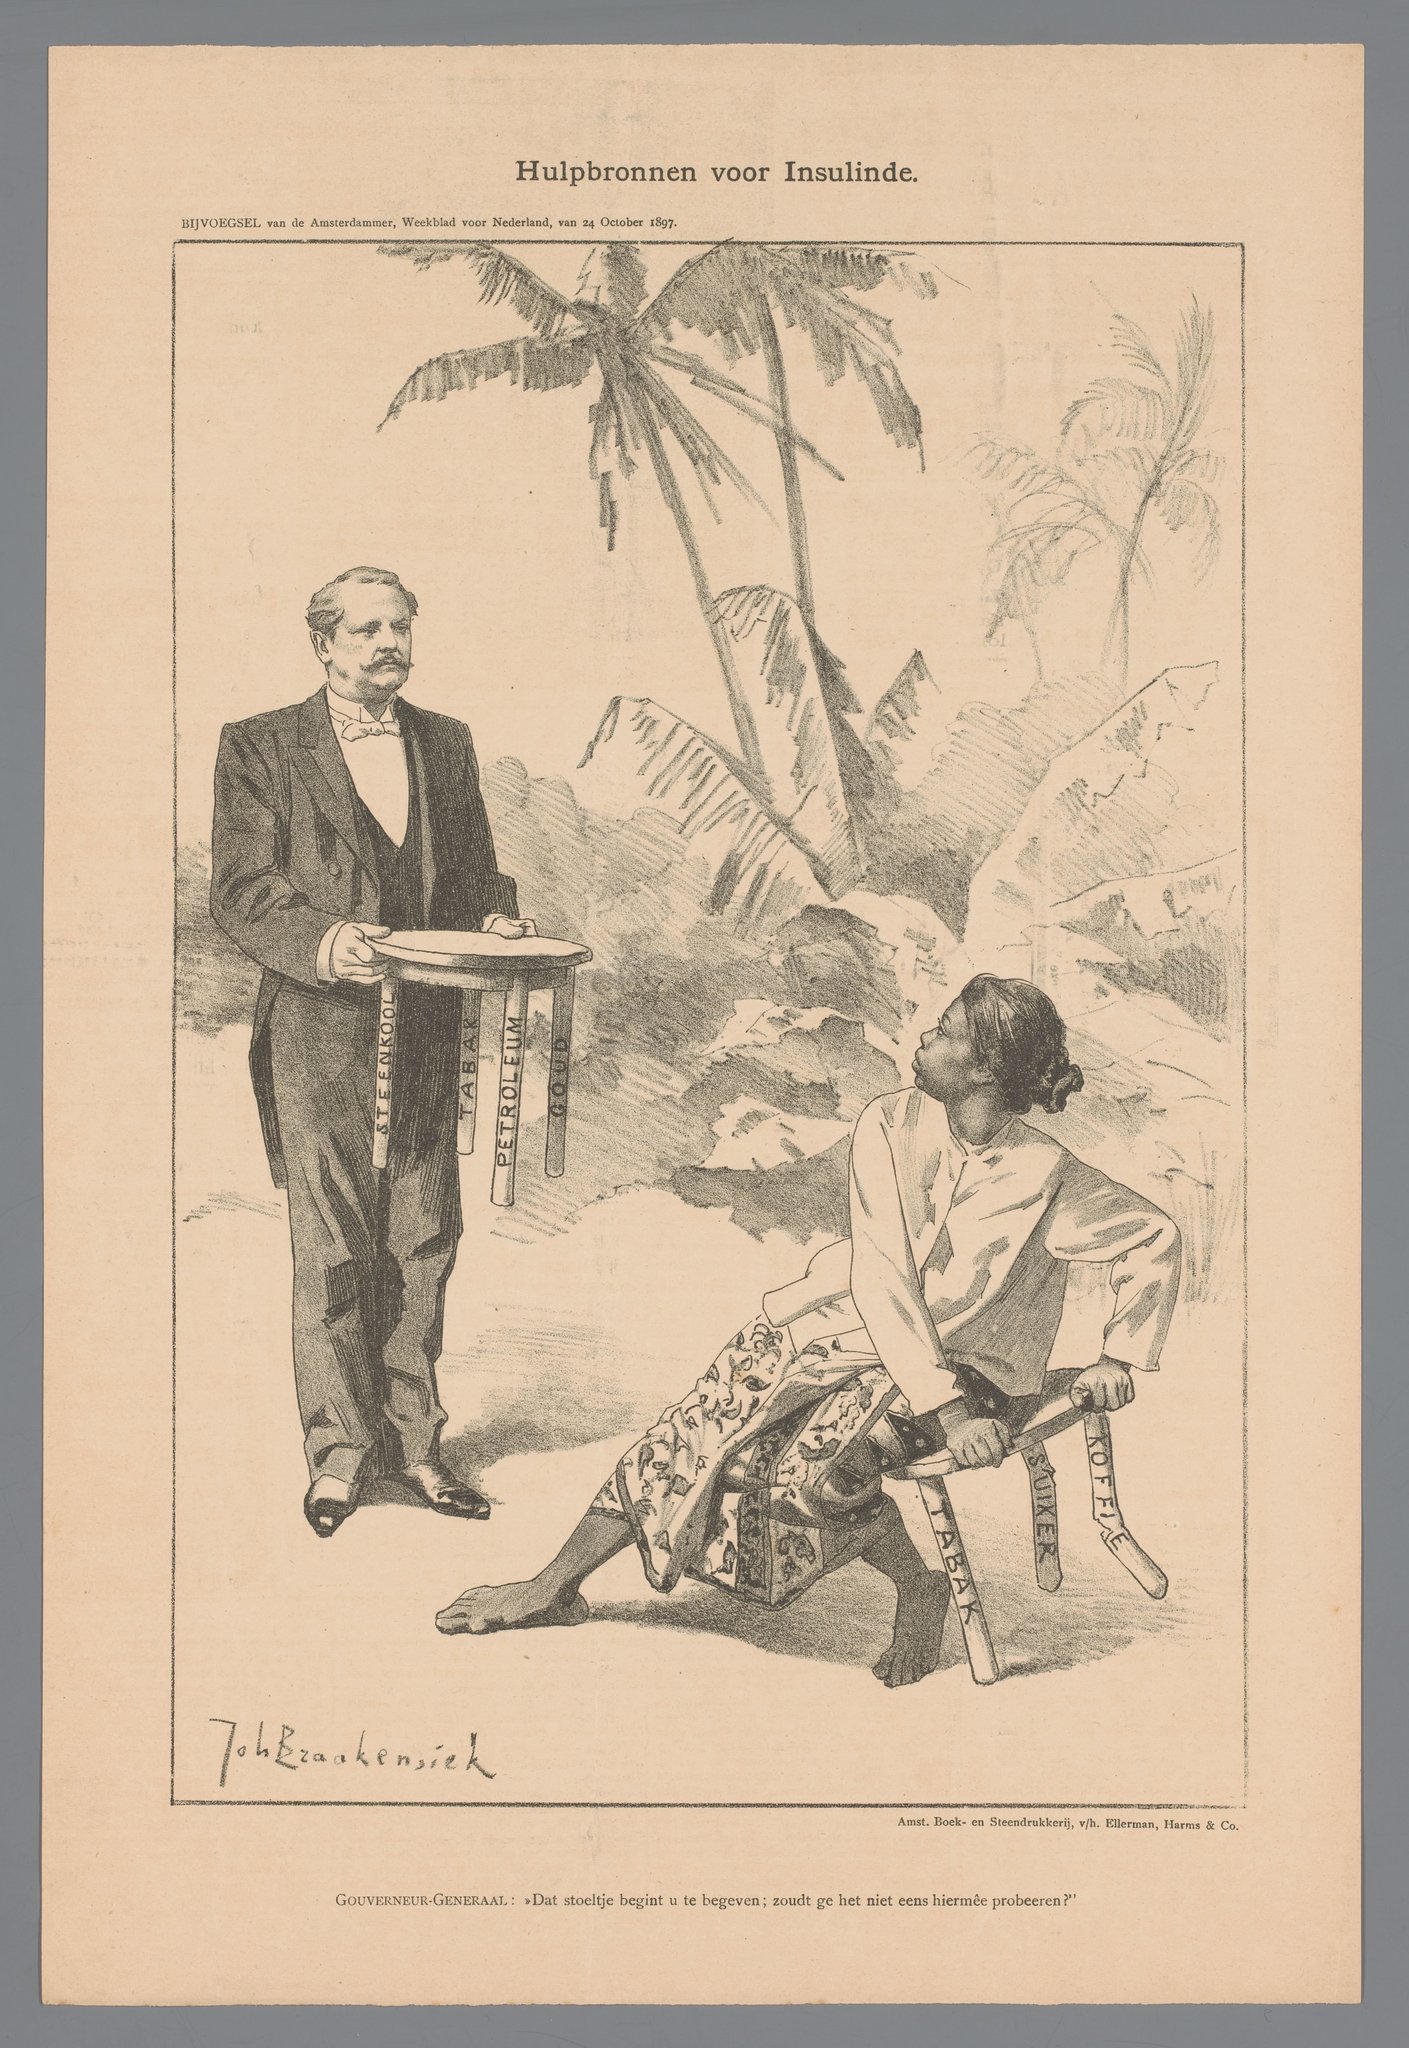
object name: cartoon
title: Hulpbronnen voor Insulinde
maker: johan braakensiek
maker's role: draughtsman, print maker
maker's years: 1858-1940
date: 1897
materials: paper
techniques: lithograph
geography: amsterdam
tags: colonial system, historical persons, stool, political caricatures and satires, dutch east indies, the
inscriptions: date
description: Prent uit het bijvoegsel van: De Amsterdammer. Weekblad voor Nederland, 24 oktober 1897.